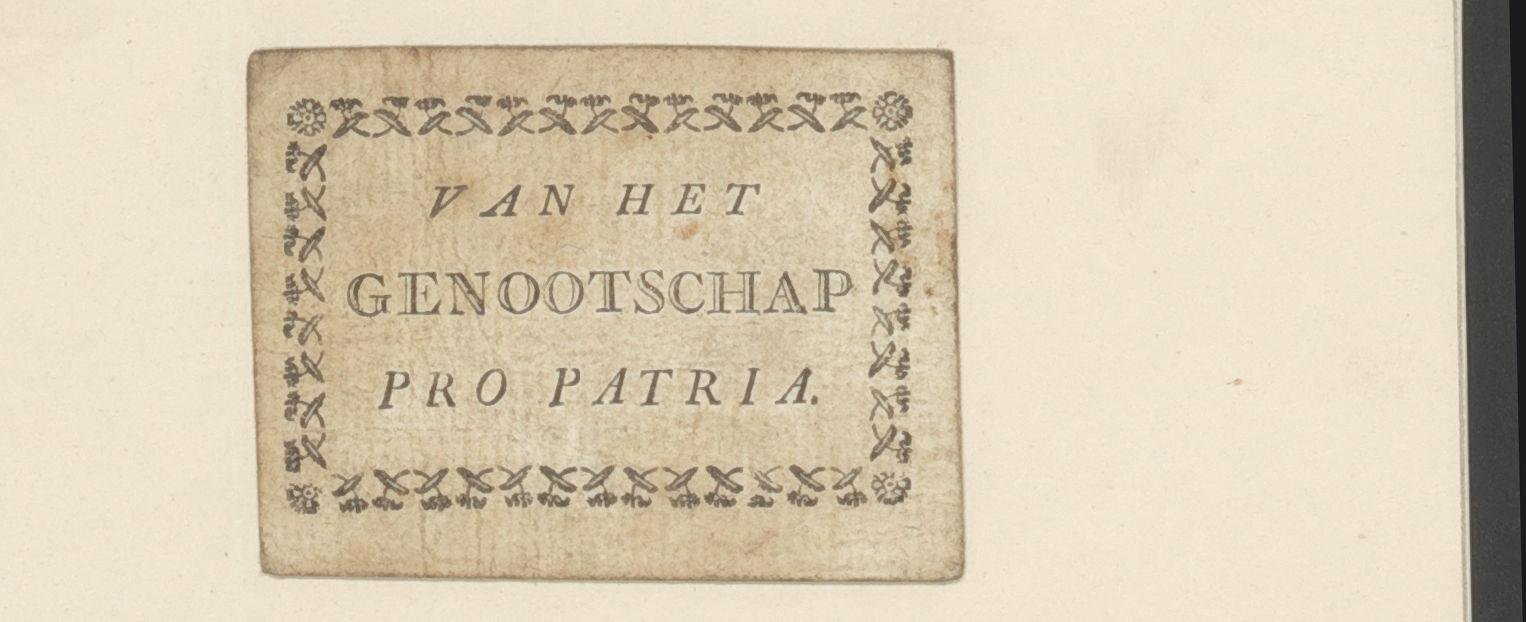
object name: print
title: Van het Genootschap Pro Patria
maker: Anonymous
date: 1783-1787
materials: paper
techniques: letterpress printing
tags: amsterdam, fourth anglo-dutch war, patriots (1780-1795)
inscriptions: stamp, collector's mark: Lugt 1641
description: Onderwerpsrubrieken binnen de Atlas Zeden en Gewoonten: Krijgswezen, Burgerbewapening.